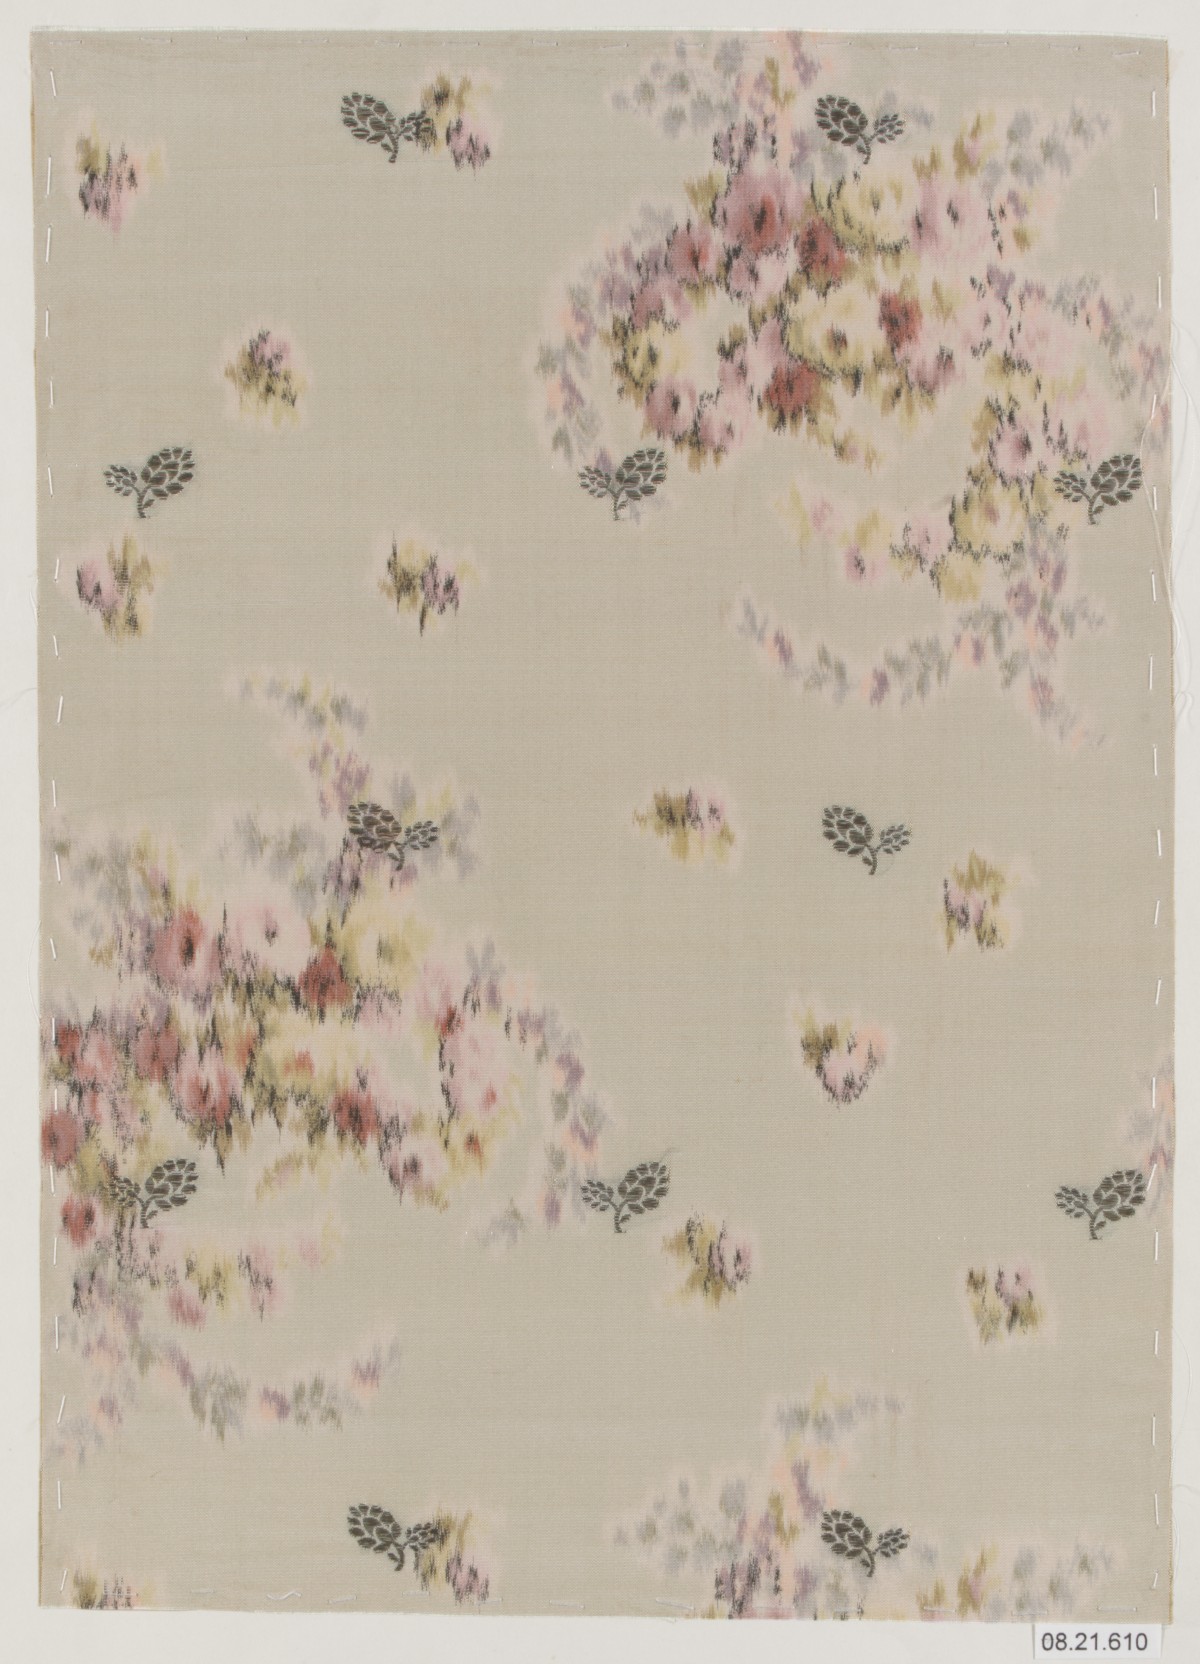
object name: textile sample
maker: Anonymous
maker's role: designer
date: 1900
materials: silk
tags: flowers